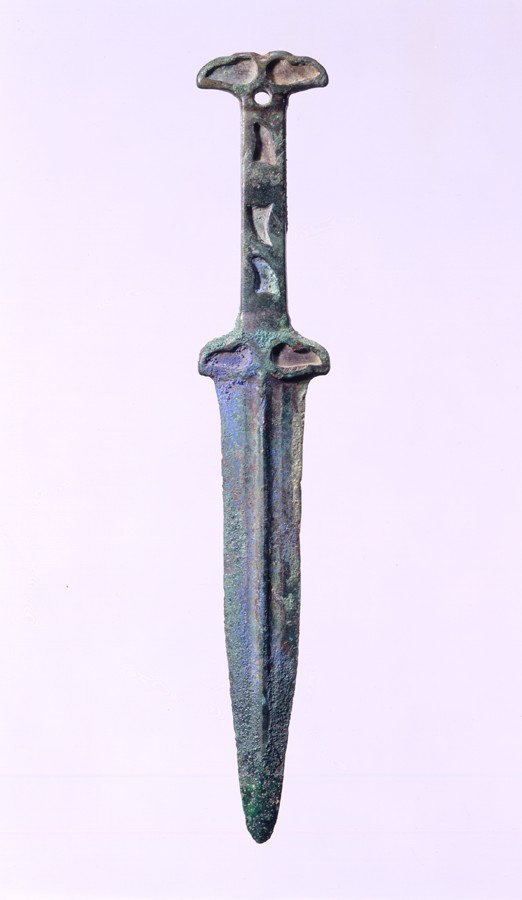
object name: sword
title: Short Sword with Birds' Heads on the Handle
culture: chinese or mongolian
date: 600-401 BCE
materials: bronze